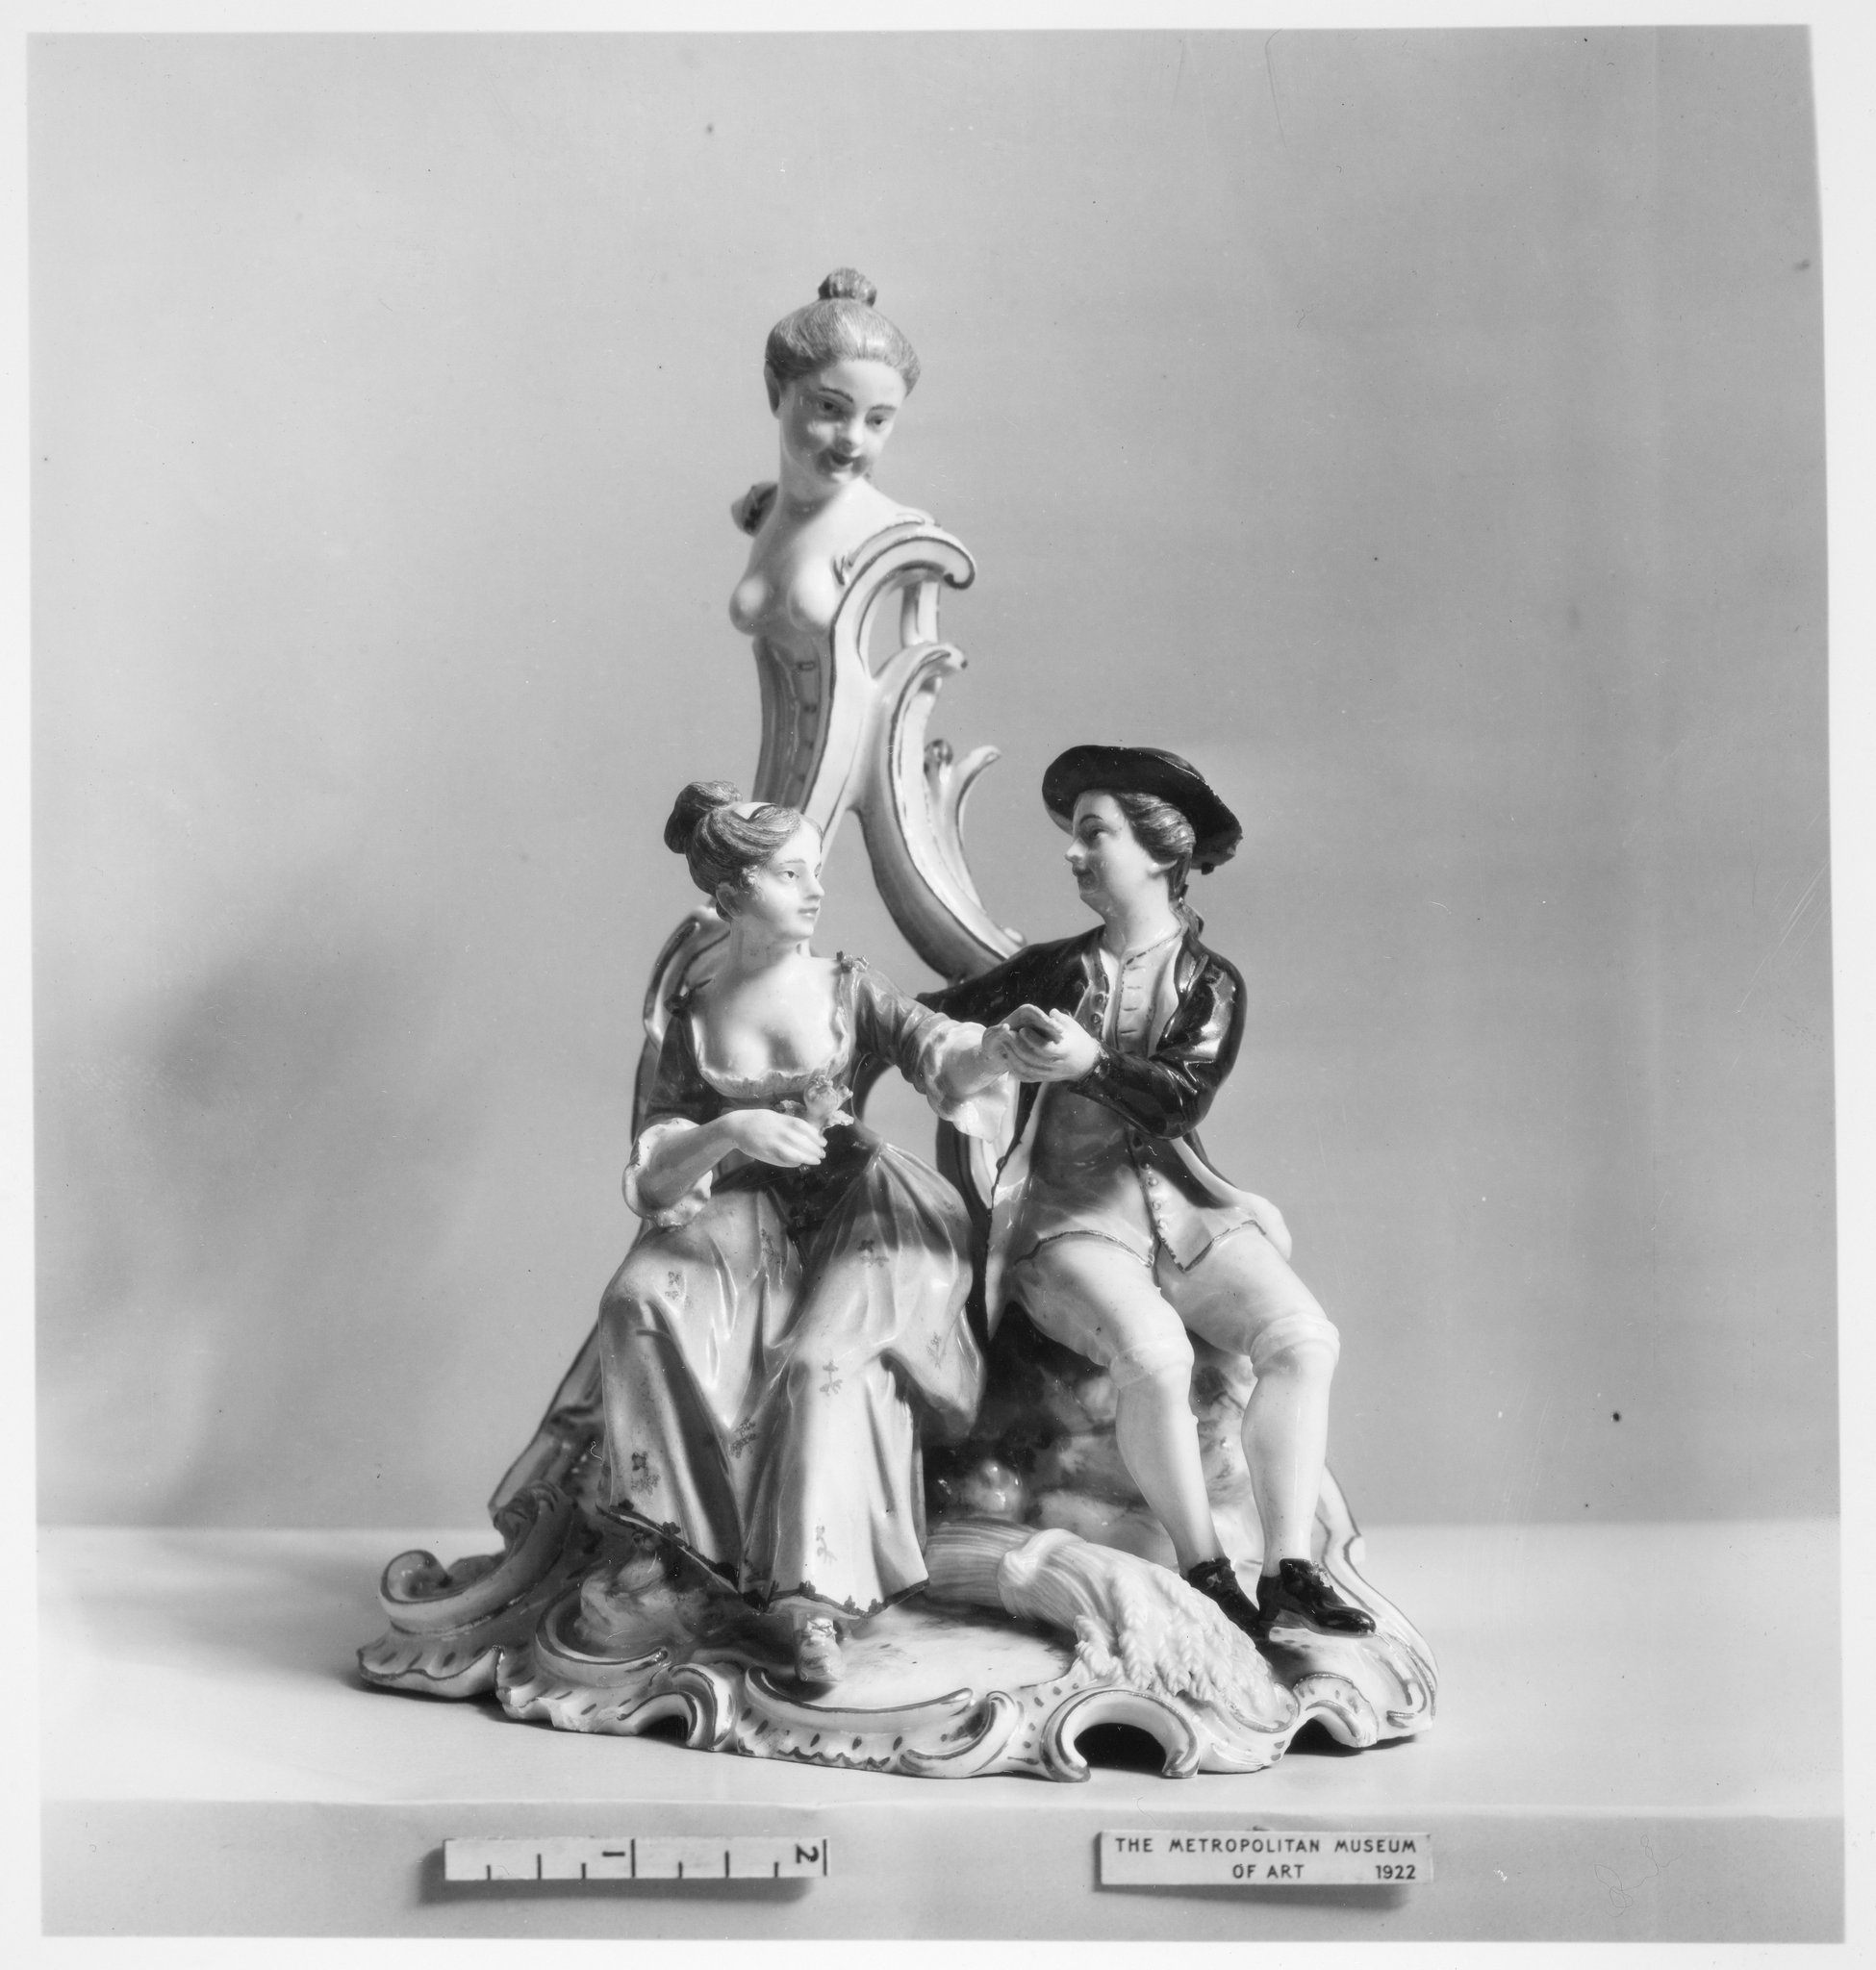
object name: group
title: Summer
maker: ludwigsburg porcelain manufactory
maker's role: manufactory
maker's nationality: german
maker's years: 1758-1824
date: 1767-1800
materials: hard paste porcelain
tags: men,women